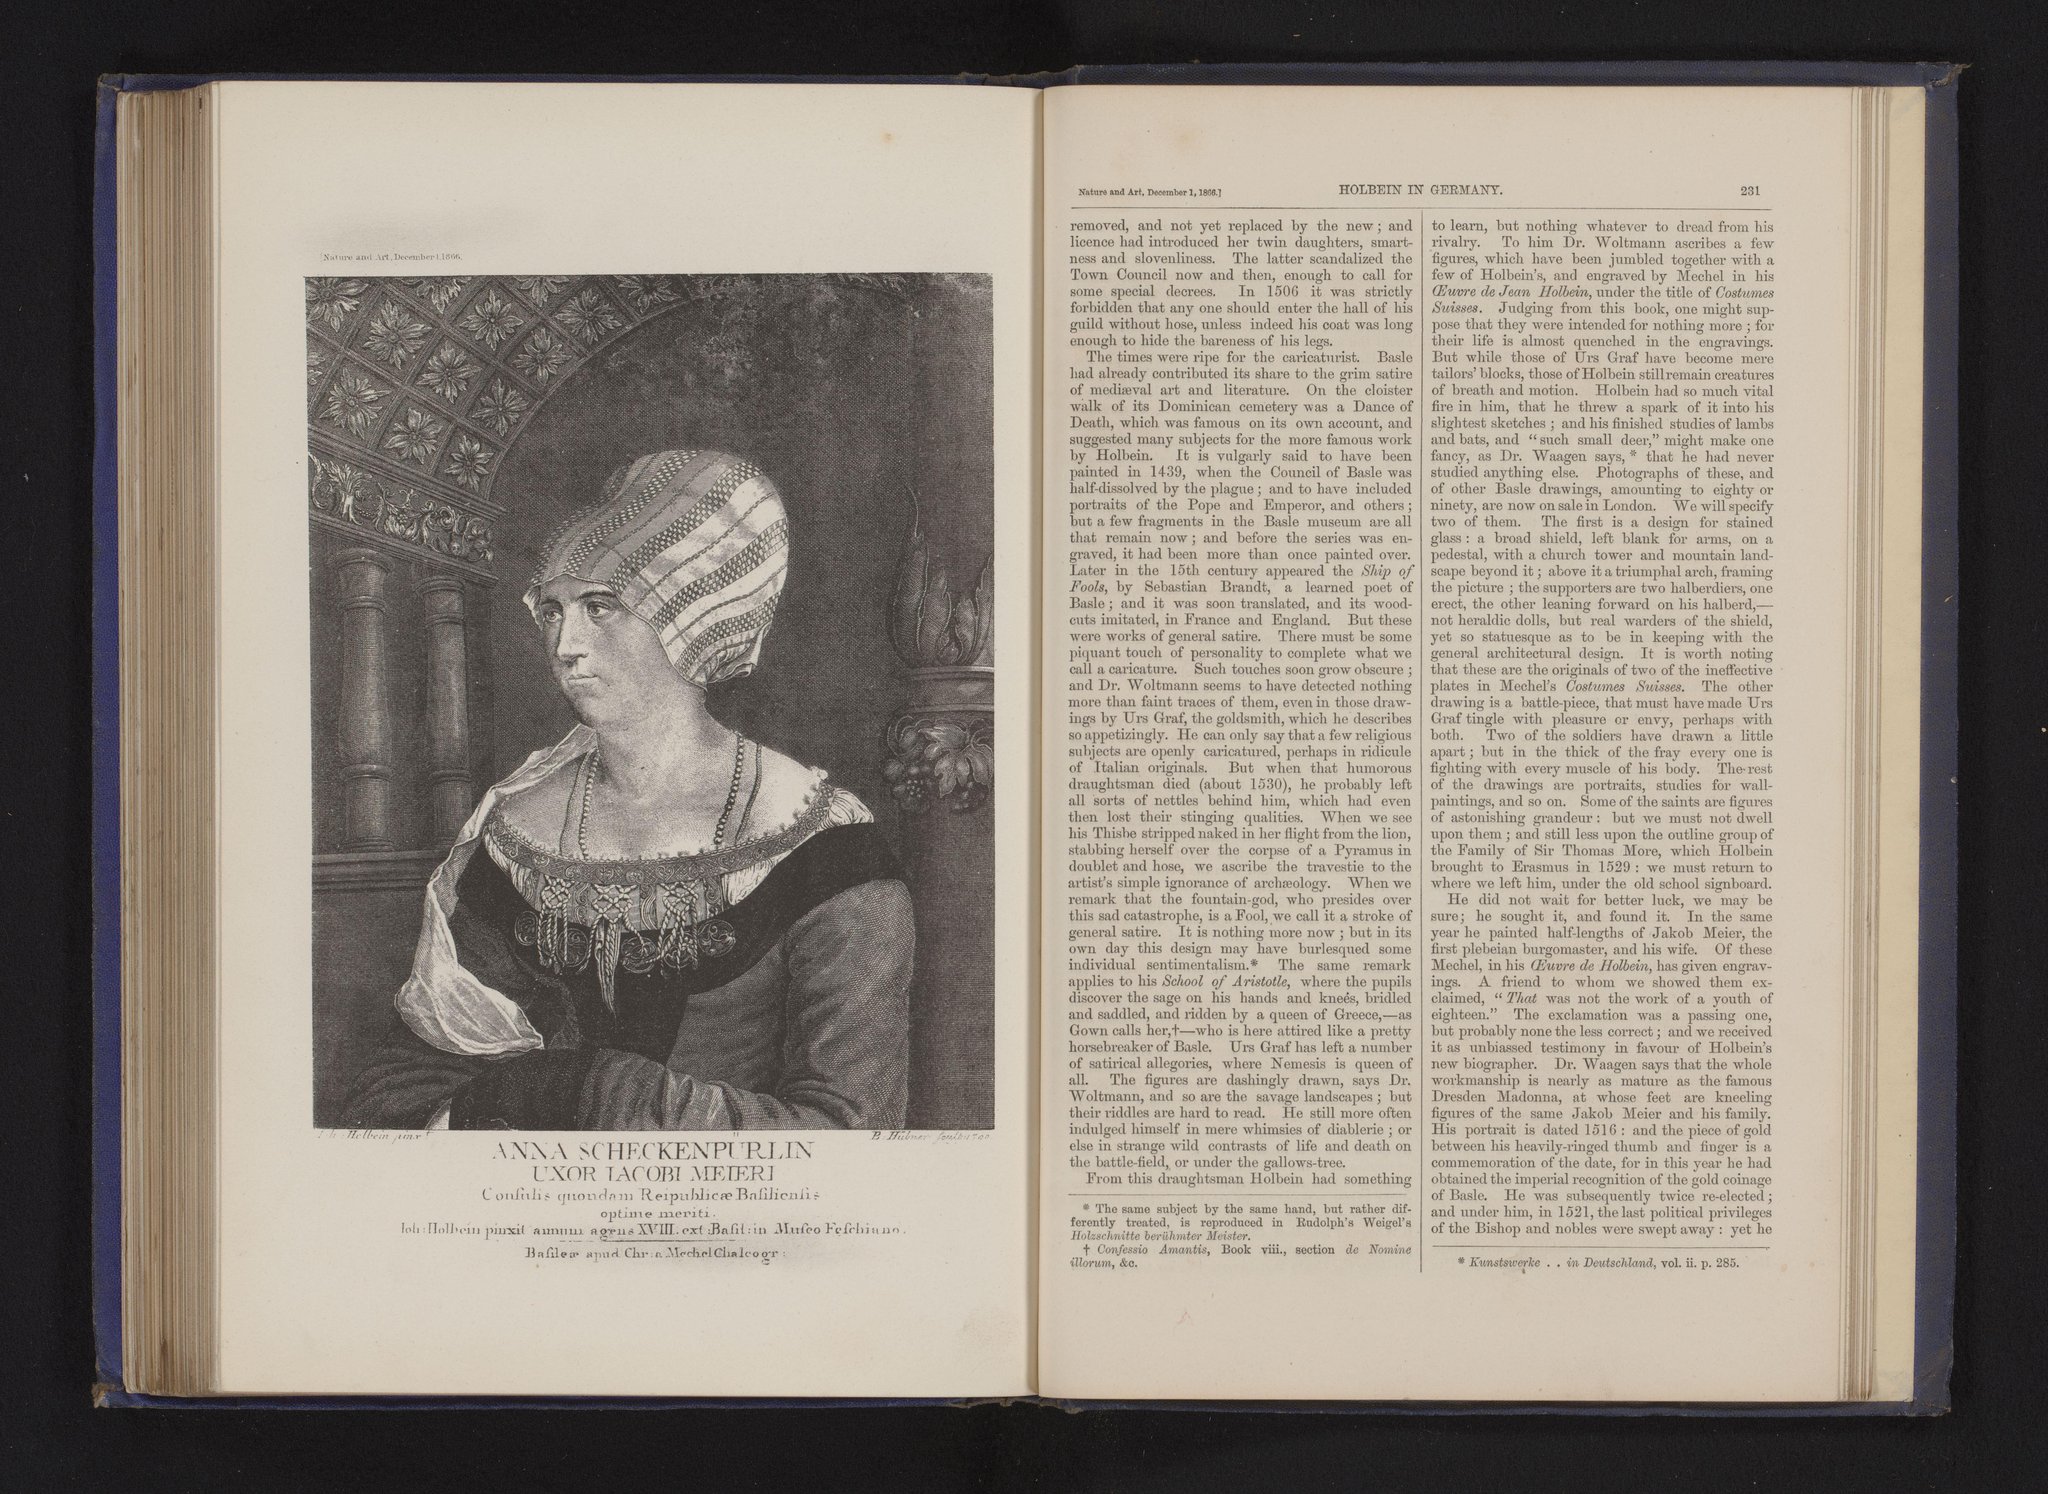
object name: page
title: Reproductie van een prent van een portret van Dorothea Kannengiesser, de vrouw van Jakob Meyer zum Hasen, door Bartholomäus Hübner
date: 1861-1866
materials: paper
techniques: photolithography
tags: historical persons - bb - woman